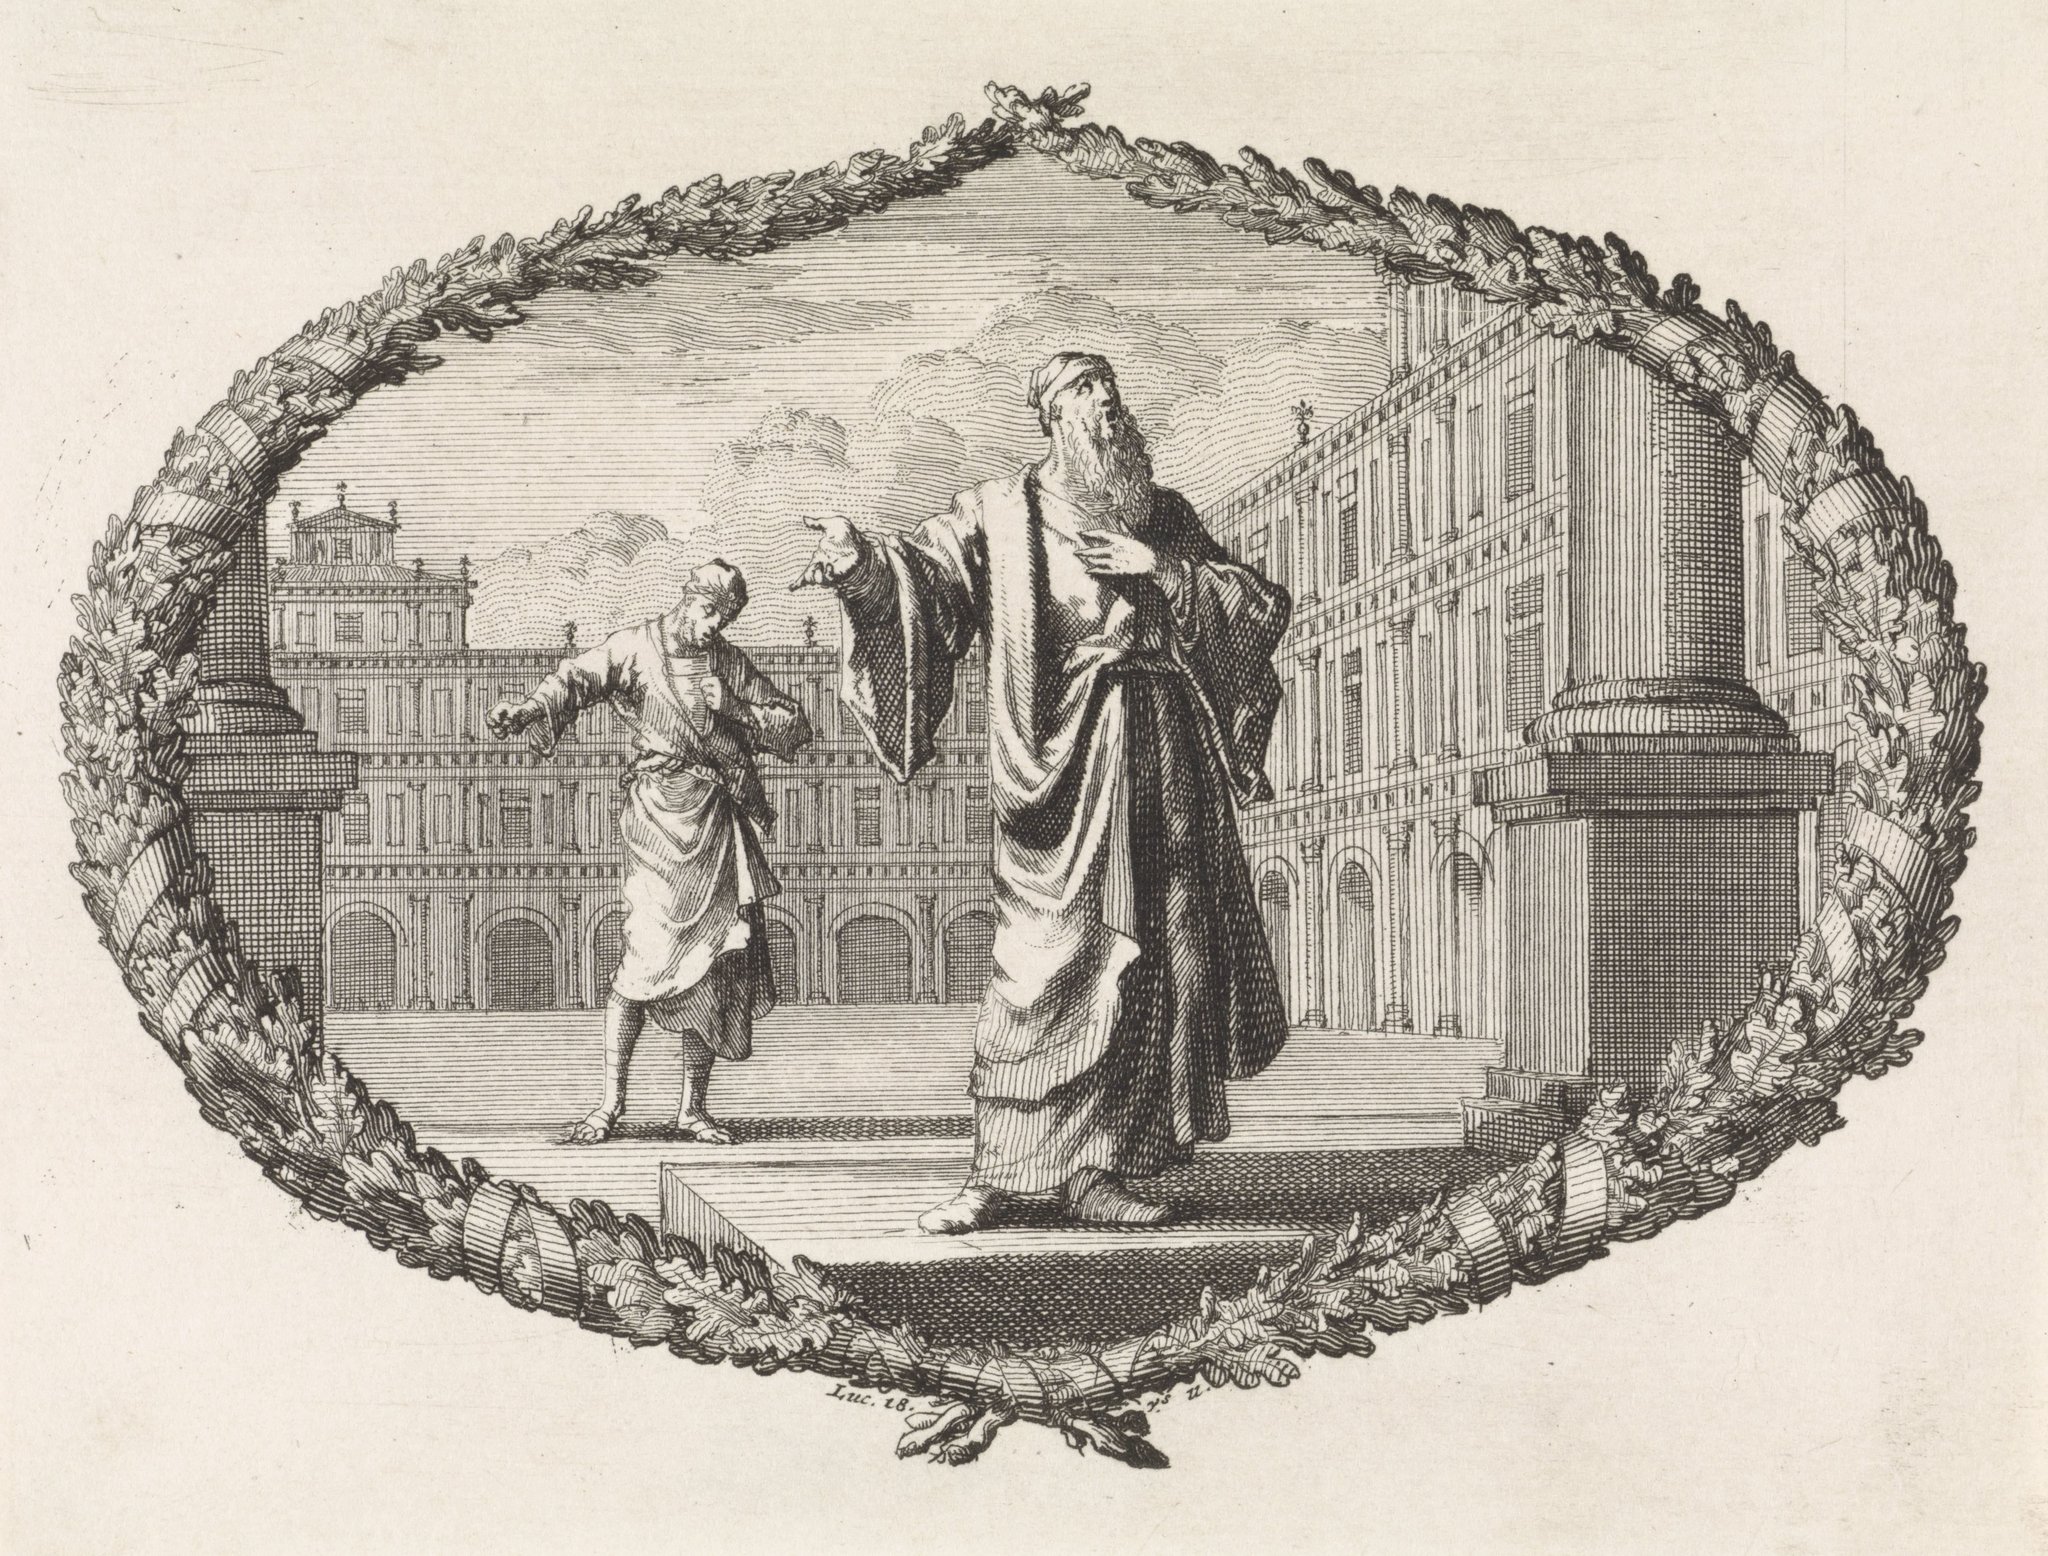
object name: print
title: Gelijkenis van een farizeeër en een tollenaar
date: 1700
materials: paper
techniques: etching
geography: amsterdam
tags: the praying pharisee and the repentant publican in the temple (luke 18:10-14), ornament ~ cartouche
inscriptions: collector's mark: Lugt 2228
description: Een voorstelling in een cartouche van palmtakken. Op de voorgrond een farizeeër bij een tempel. Hij bidt tot God zonder nederigheid. Op de achtergrond een tollenaar, die onderdanig zijn hoofd buigt tijdens het bidden. Onder de cartouche de Bijbelreferentie Luc. 18:11.